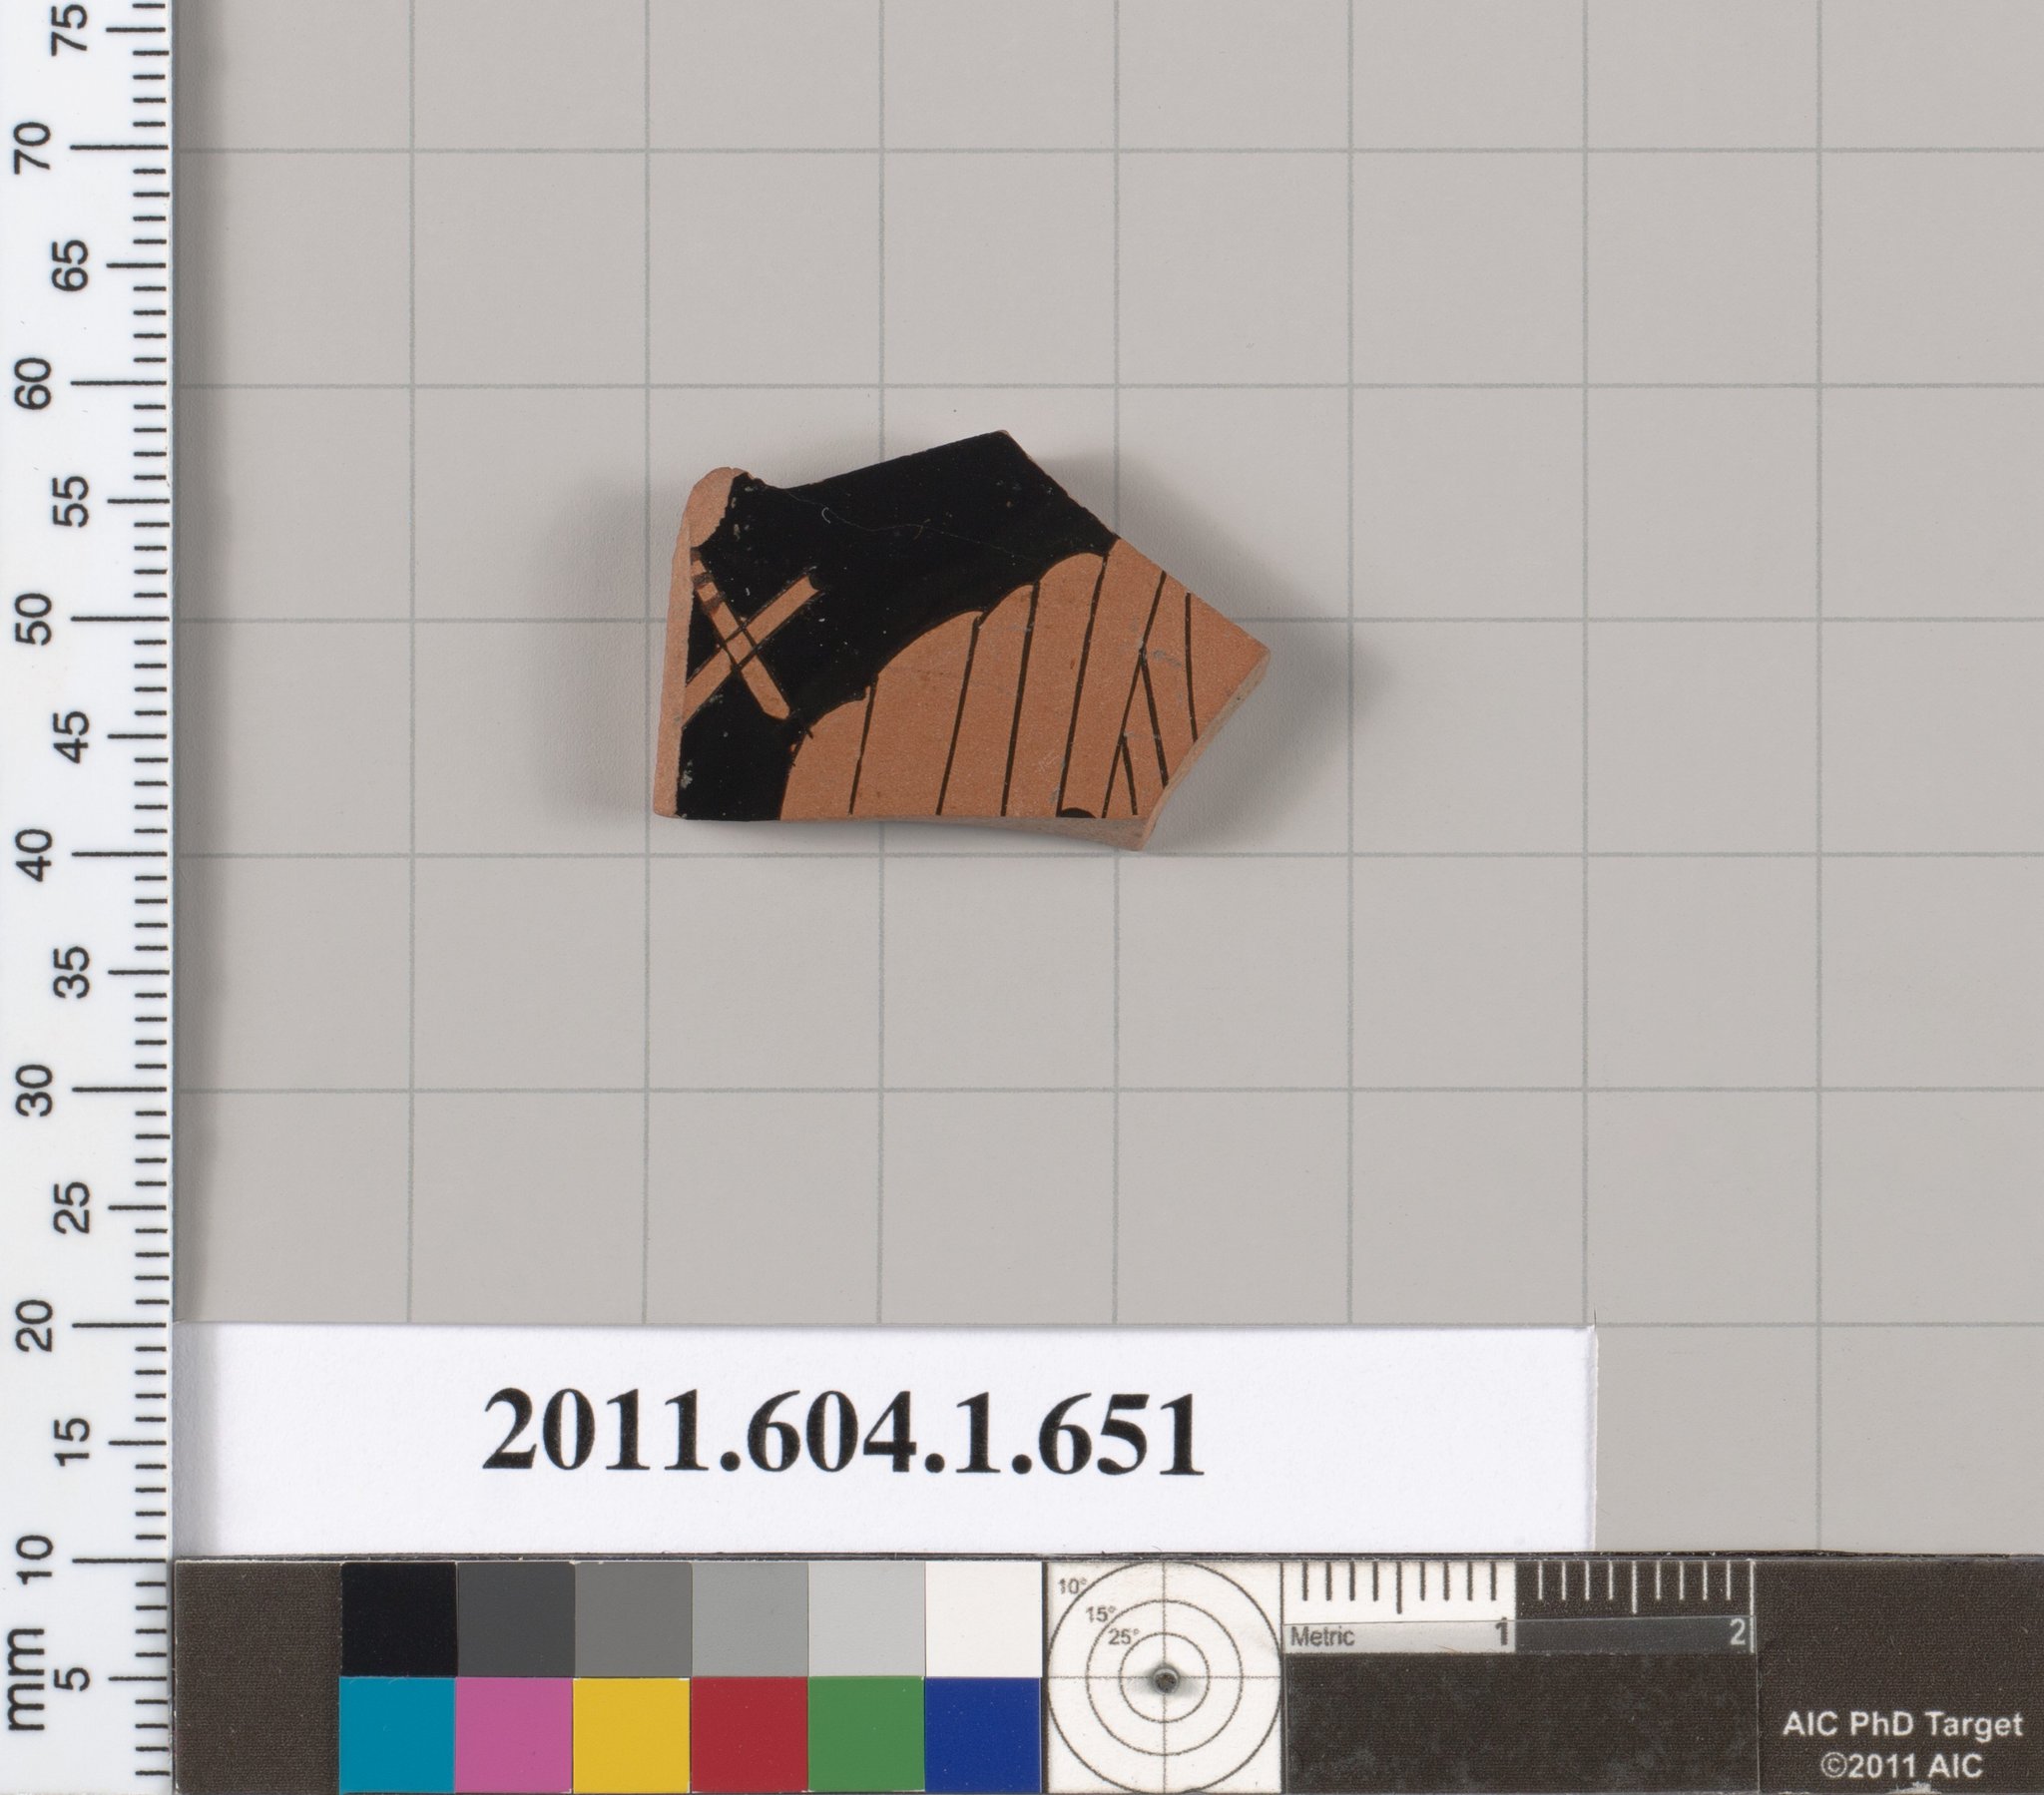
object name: kylix fragment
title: Terracotta fragment of a kylix (drinking cup)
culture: greek, attic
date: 475-451 BCE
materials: terracotta